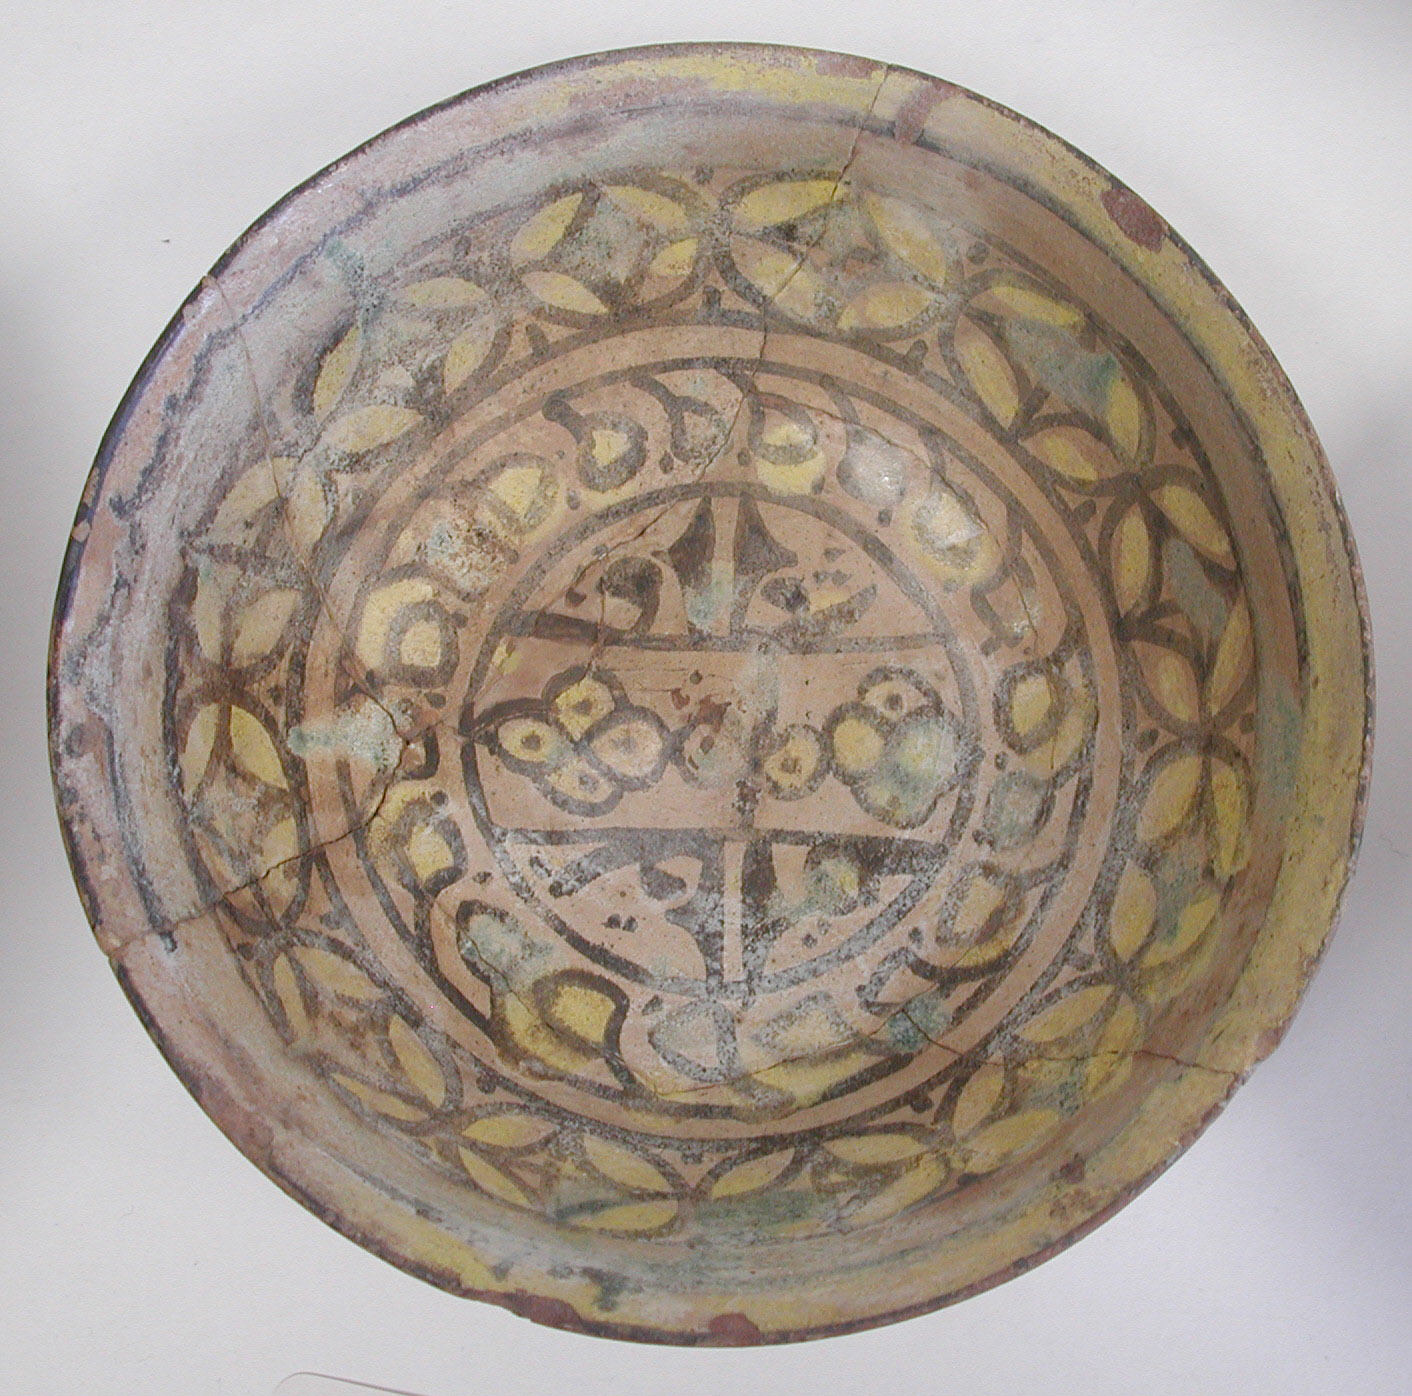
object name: bowl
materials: earthenware, glaze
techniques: polychrome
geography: iran